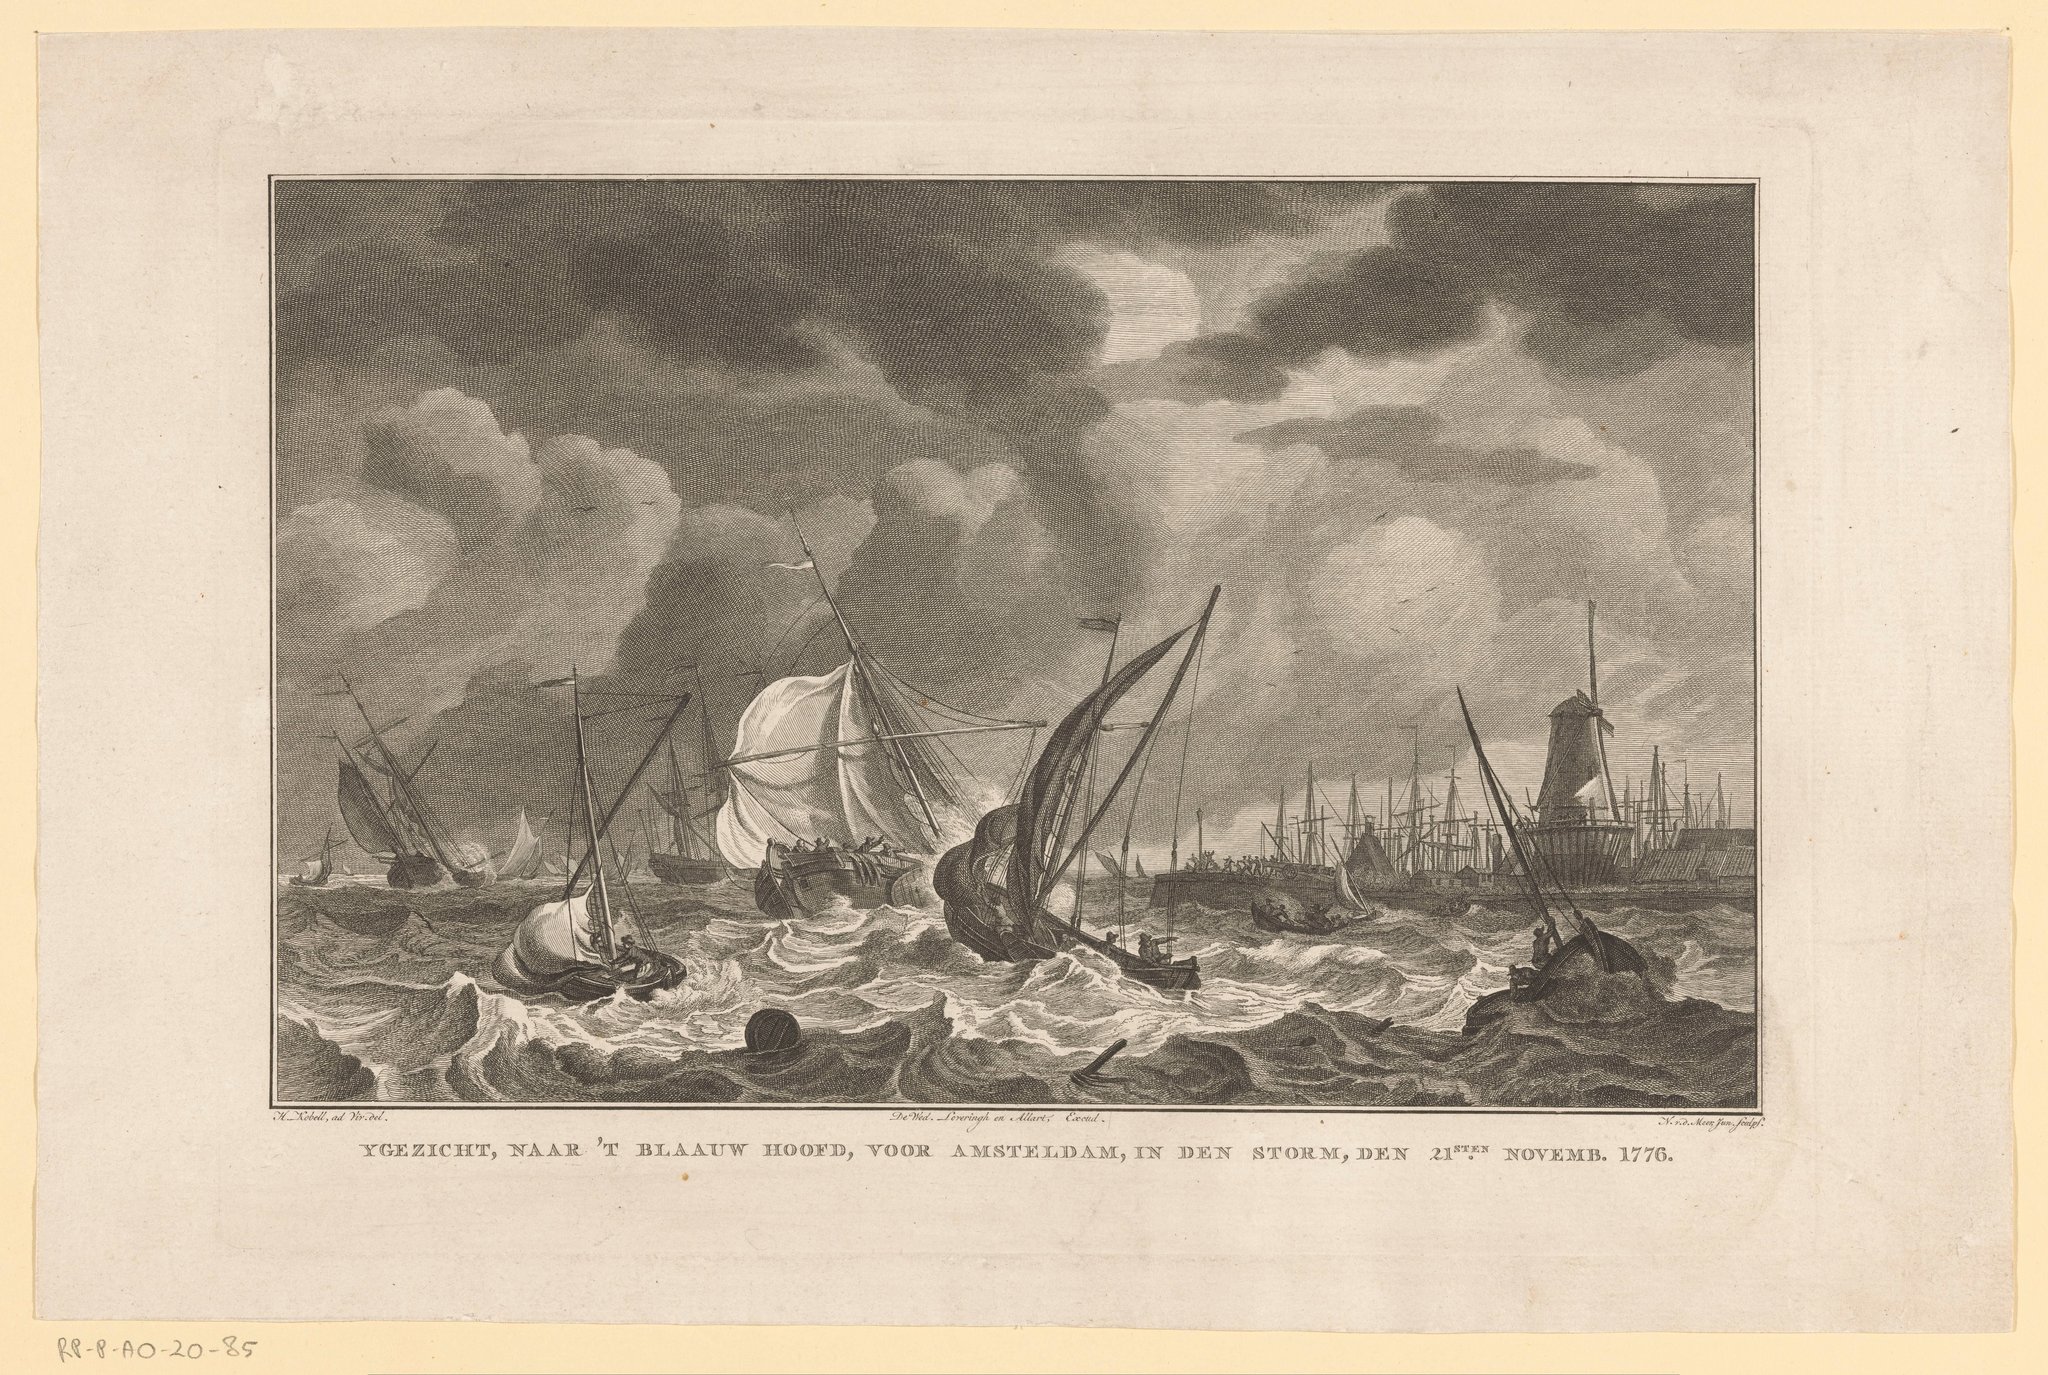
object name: print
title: Ygezicht, naar 't Blaauw Hoofd, voor Amsteldam, in den storm, den 21.sten novemb. 1776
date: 1778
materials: paper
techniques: engraving, etching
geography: amsterdam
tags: sailing-ship, sailing-boat, storm at sea, amsterdam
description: Prent ook gebruikt in: Hering, Johan Hendrik. Bespiegeling over Neêrlandsch waternood, tusschen den XXIsten en XXIIsten november, MDCCLXXVI. Amsterdam: Johannes Allart, 1778, tussen p. 12 en 13. Zie RP-P-OB-23.509 voor eerdere en RP-P-OB-23.436 voor latere staat.